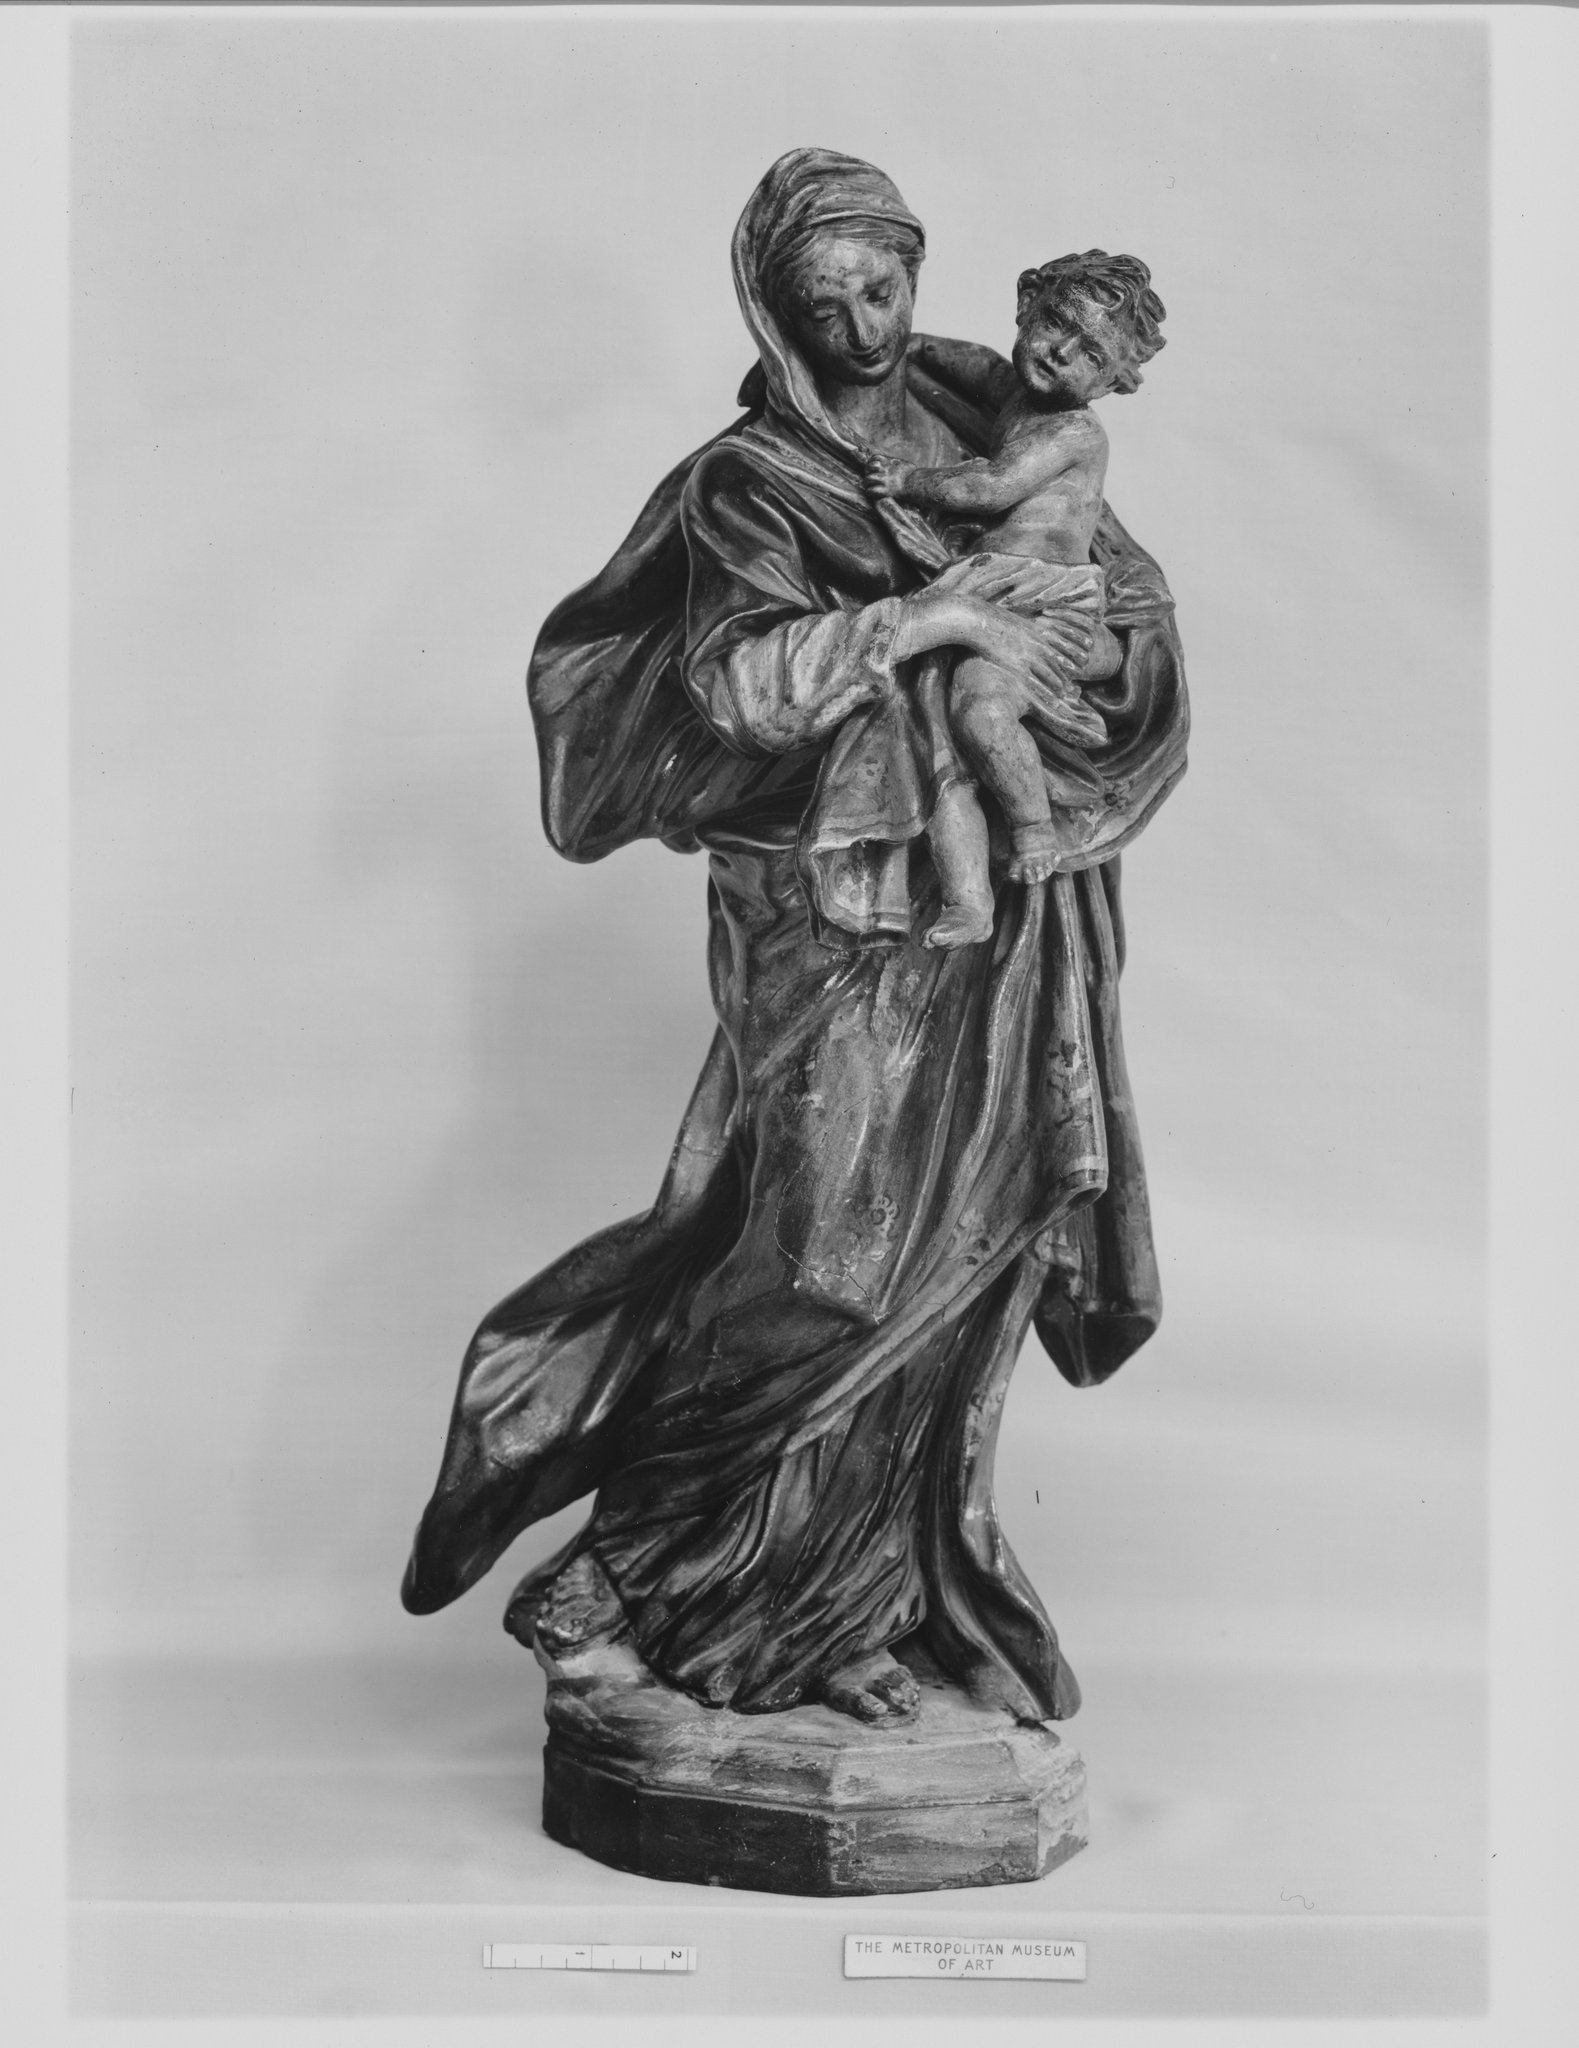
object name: statuette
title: Madonna and Child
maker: giuseppe mazza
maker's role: artist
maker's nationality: italian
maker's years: 1653-1741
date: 1701-1800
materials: gilt, terracotta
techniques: polychrome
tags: madonna and child